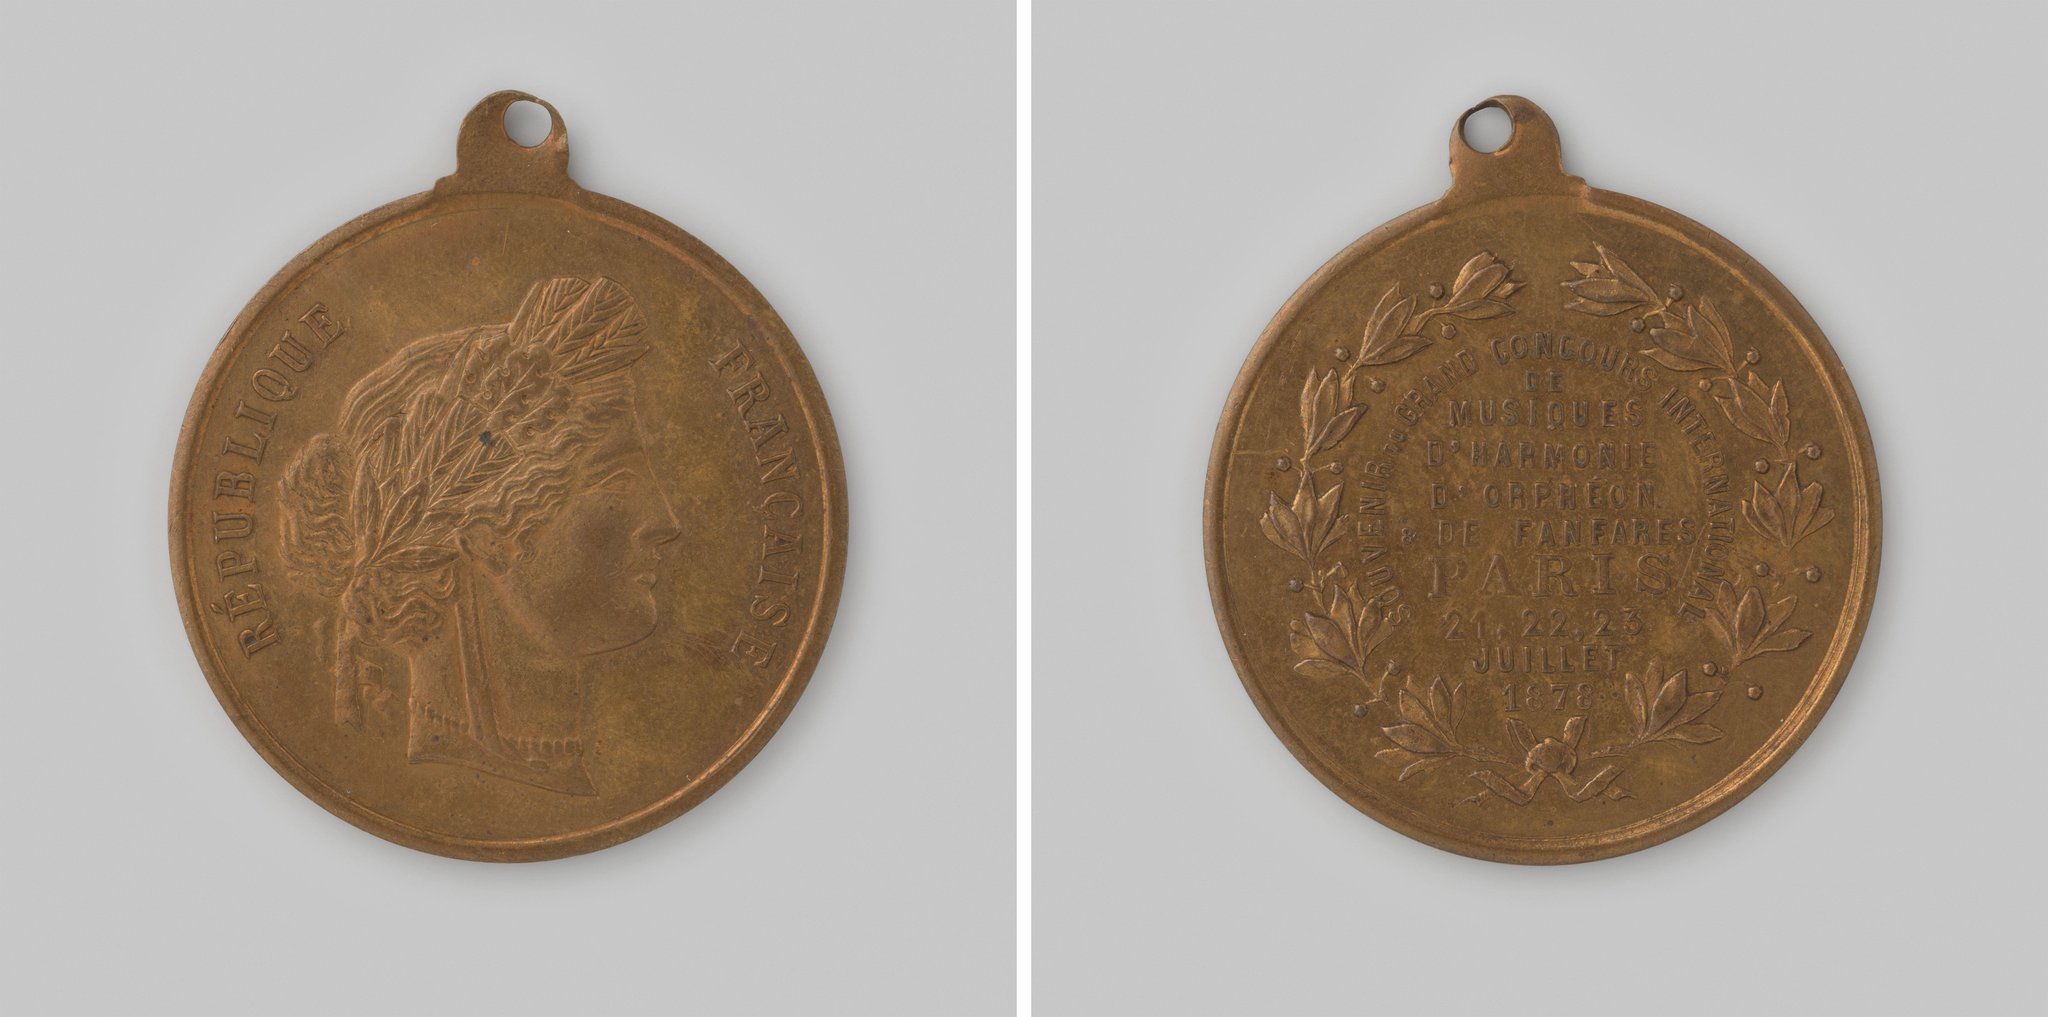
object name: history medal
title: Muziekconcours te Parijs 1878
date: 1878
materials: brass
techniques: striking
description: Messing penning met draagoog, op de voorzijde het portret van Ceres naar rechts met omschrift, op de keerzijde negen regels tekst met omschrift tussen samengestrikte lauwertakken.